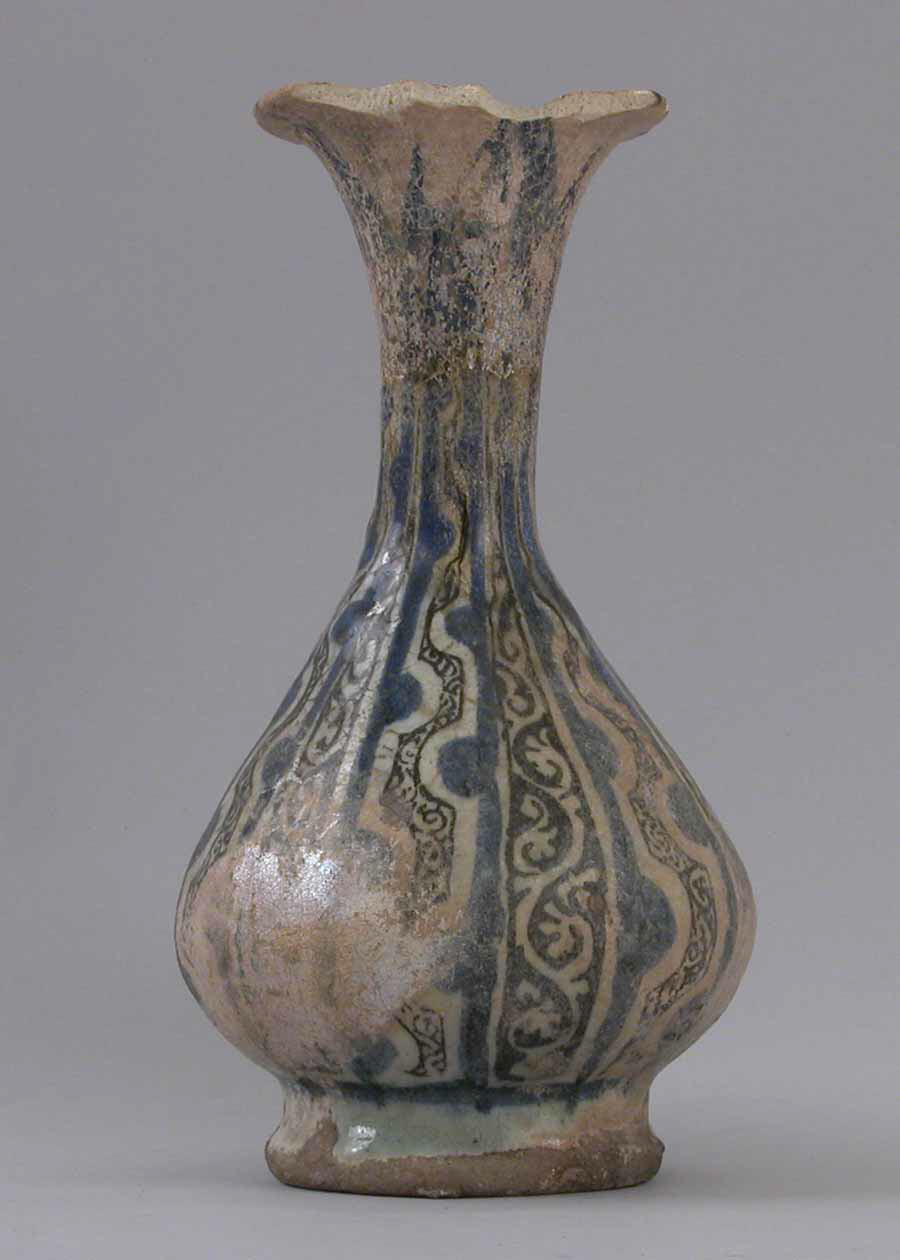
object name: vase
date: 1301-1400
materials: stonepaste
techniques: painting, underglaze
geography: syria